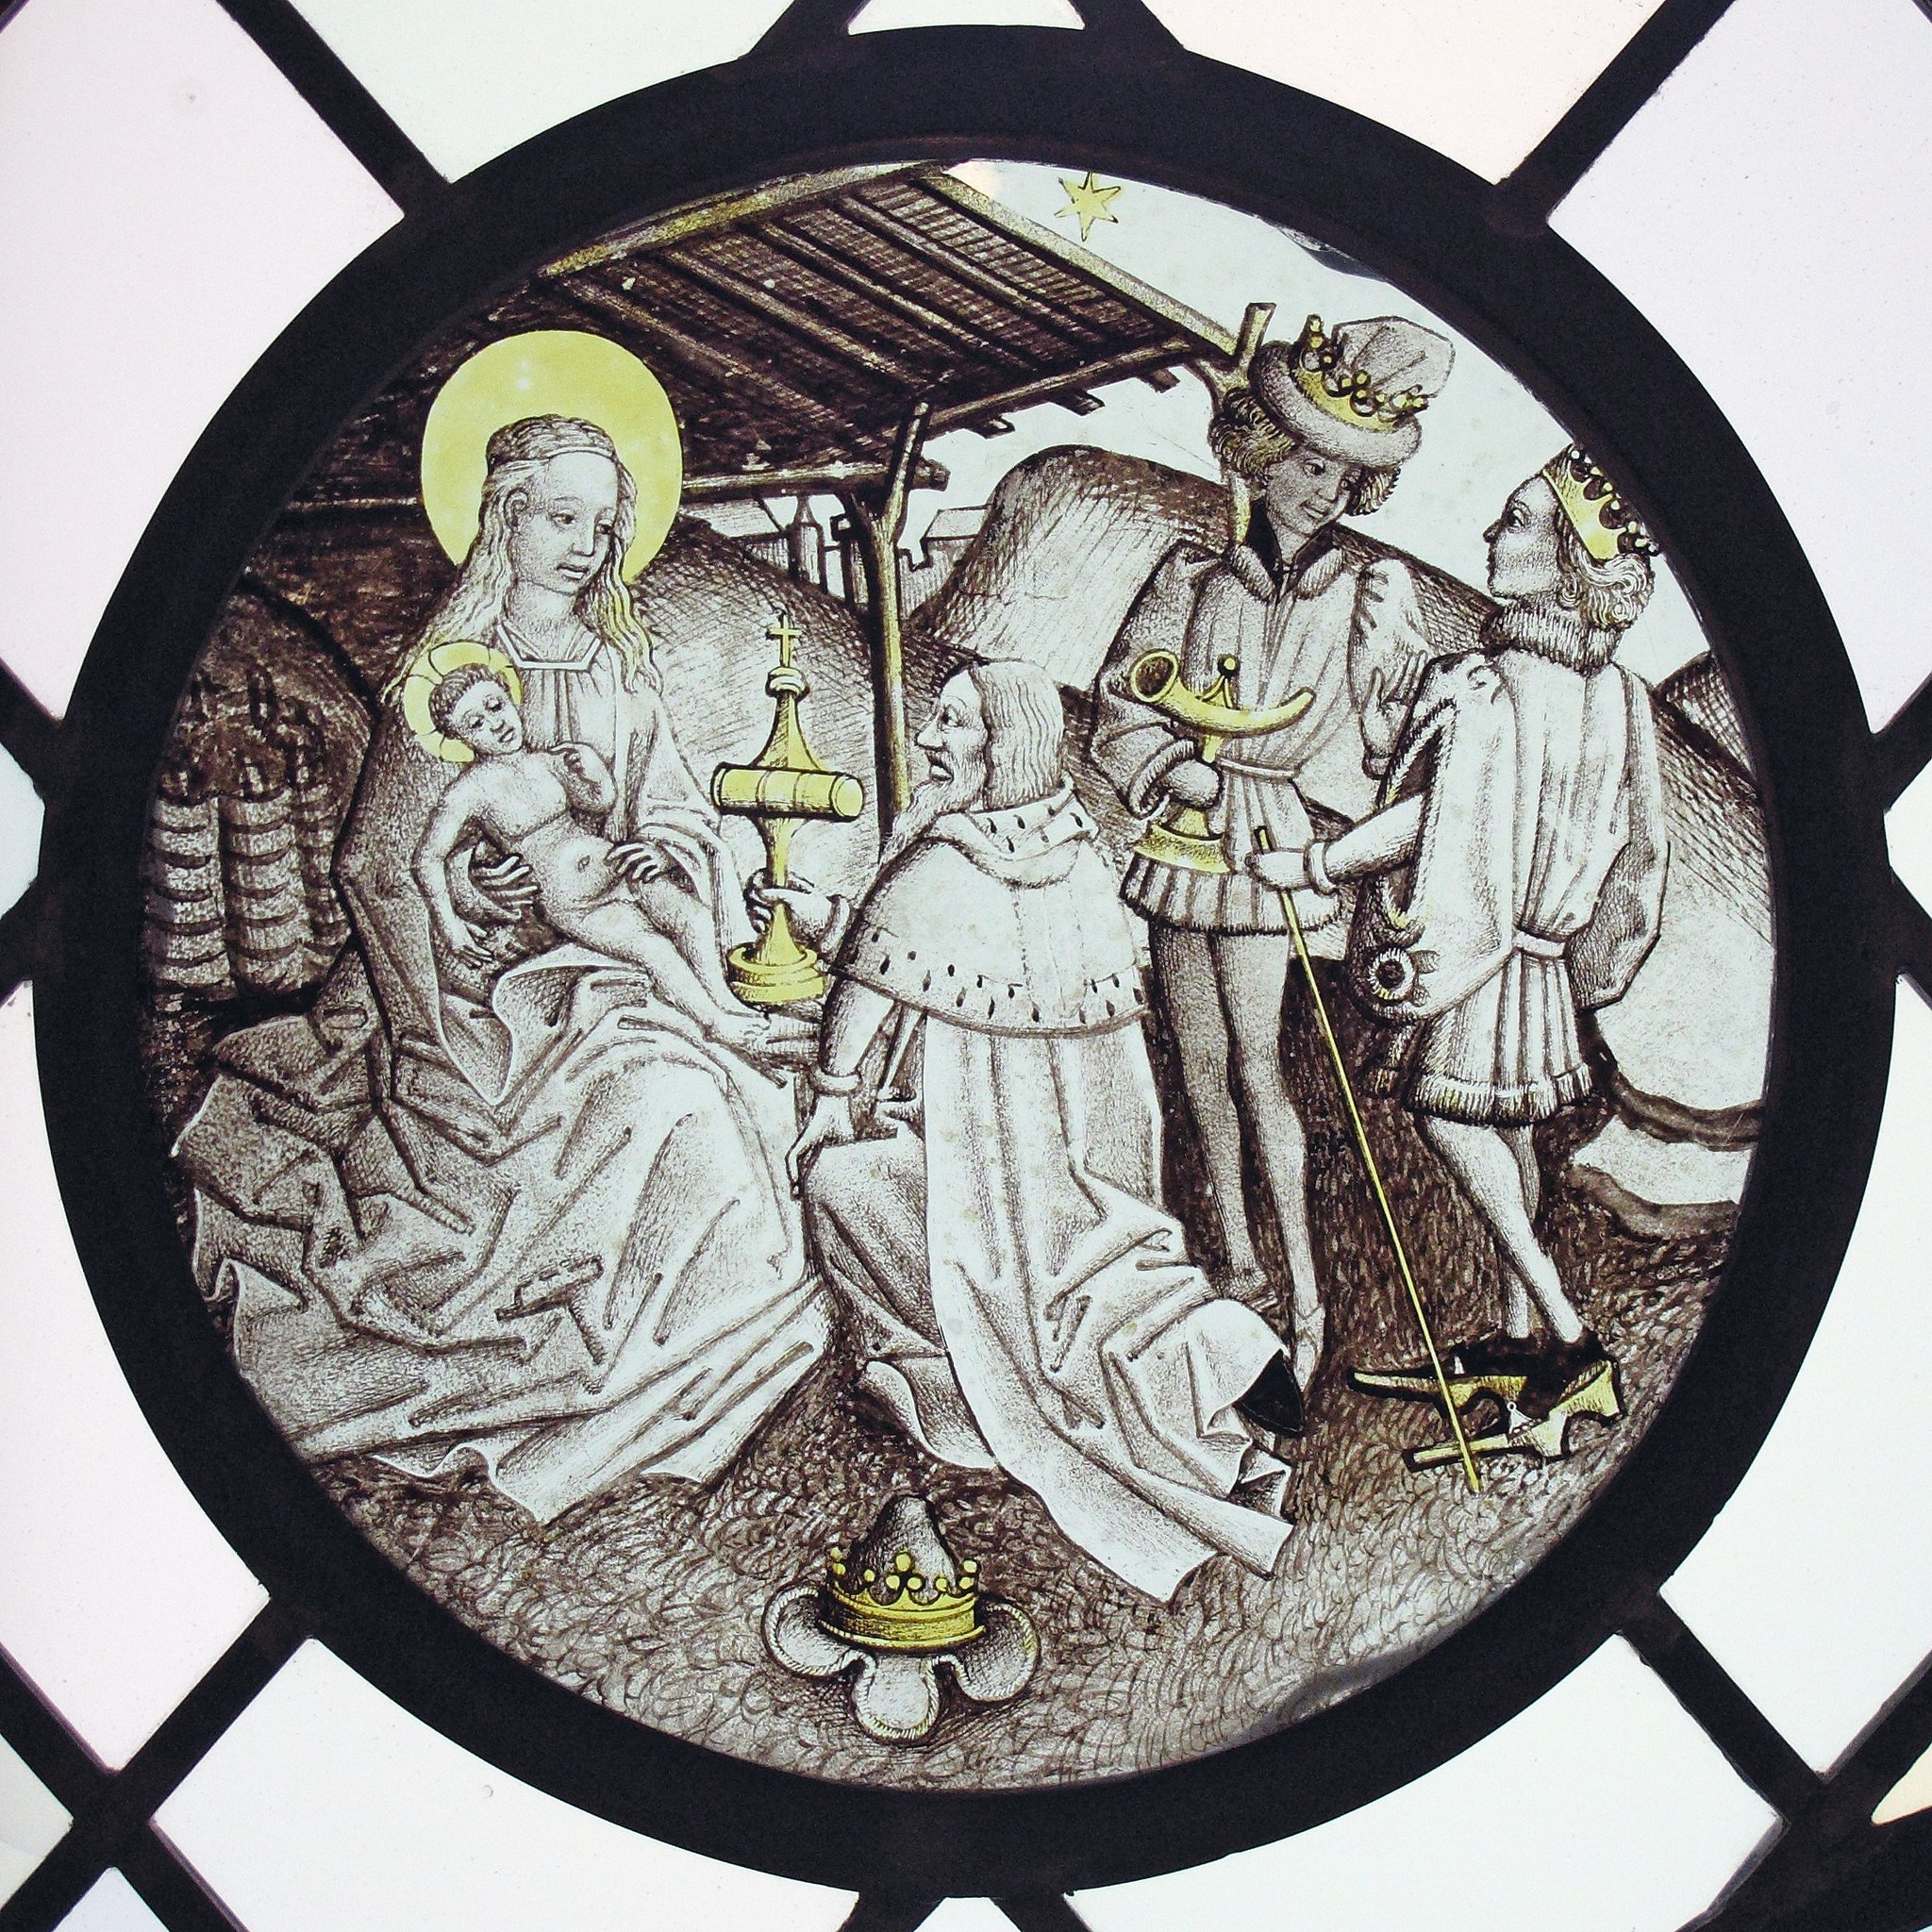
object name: roundel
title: Roundel with Adoration of the Magi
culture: german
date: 1480-1490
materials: glass, paint, pigment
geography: germany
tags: men,virgin mary,jesus,adoration of the magi